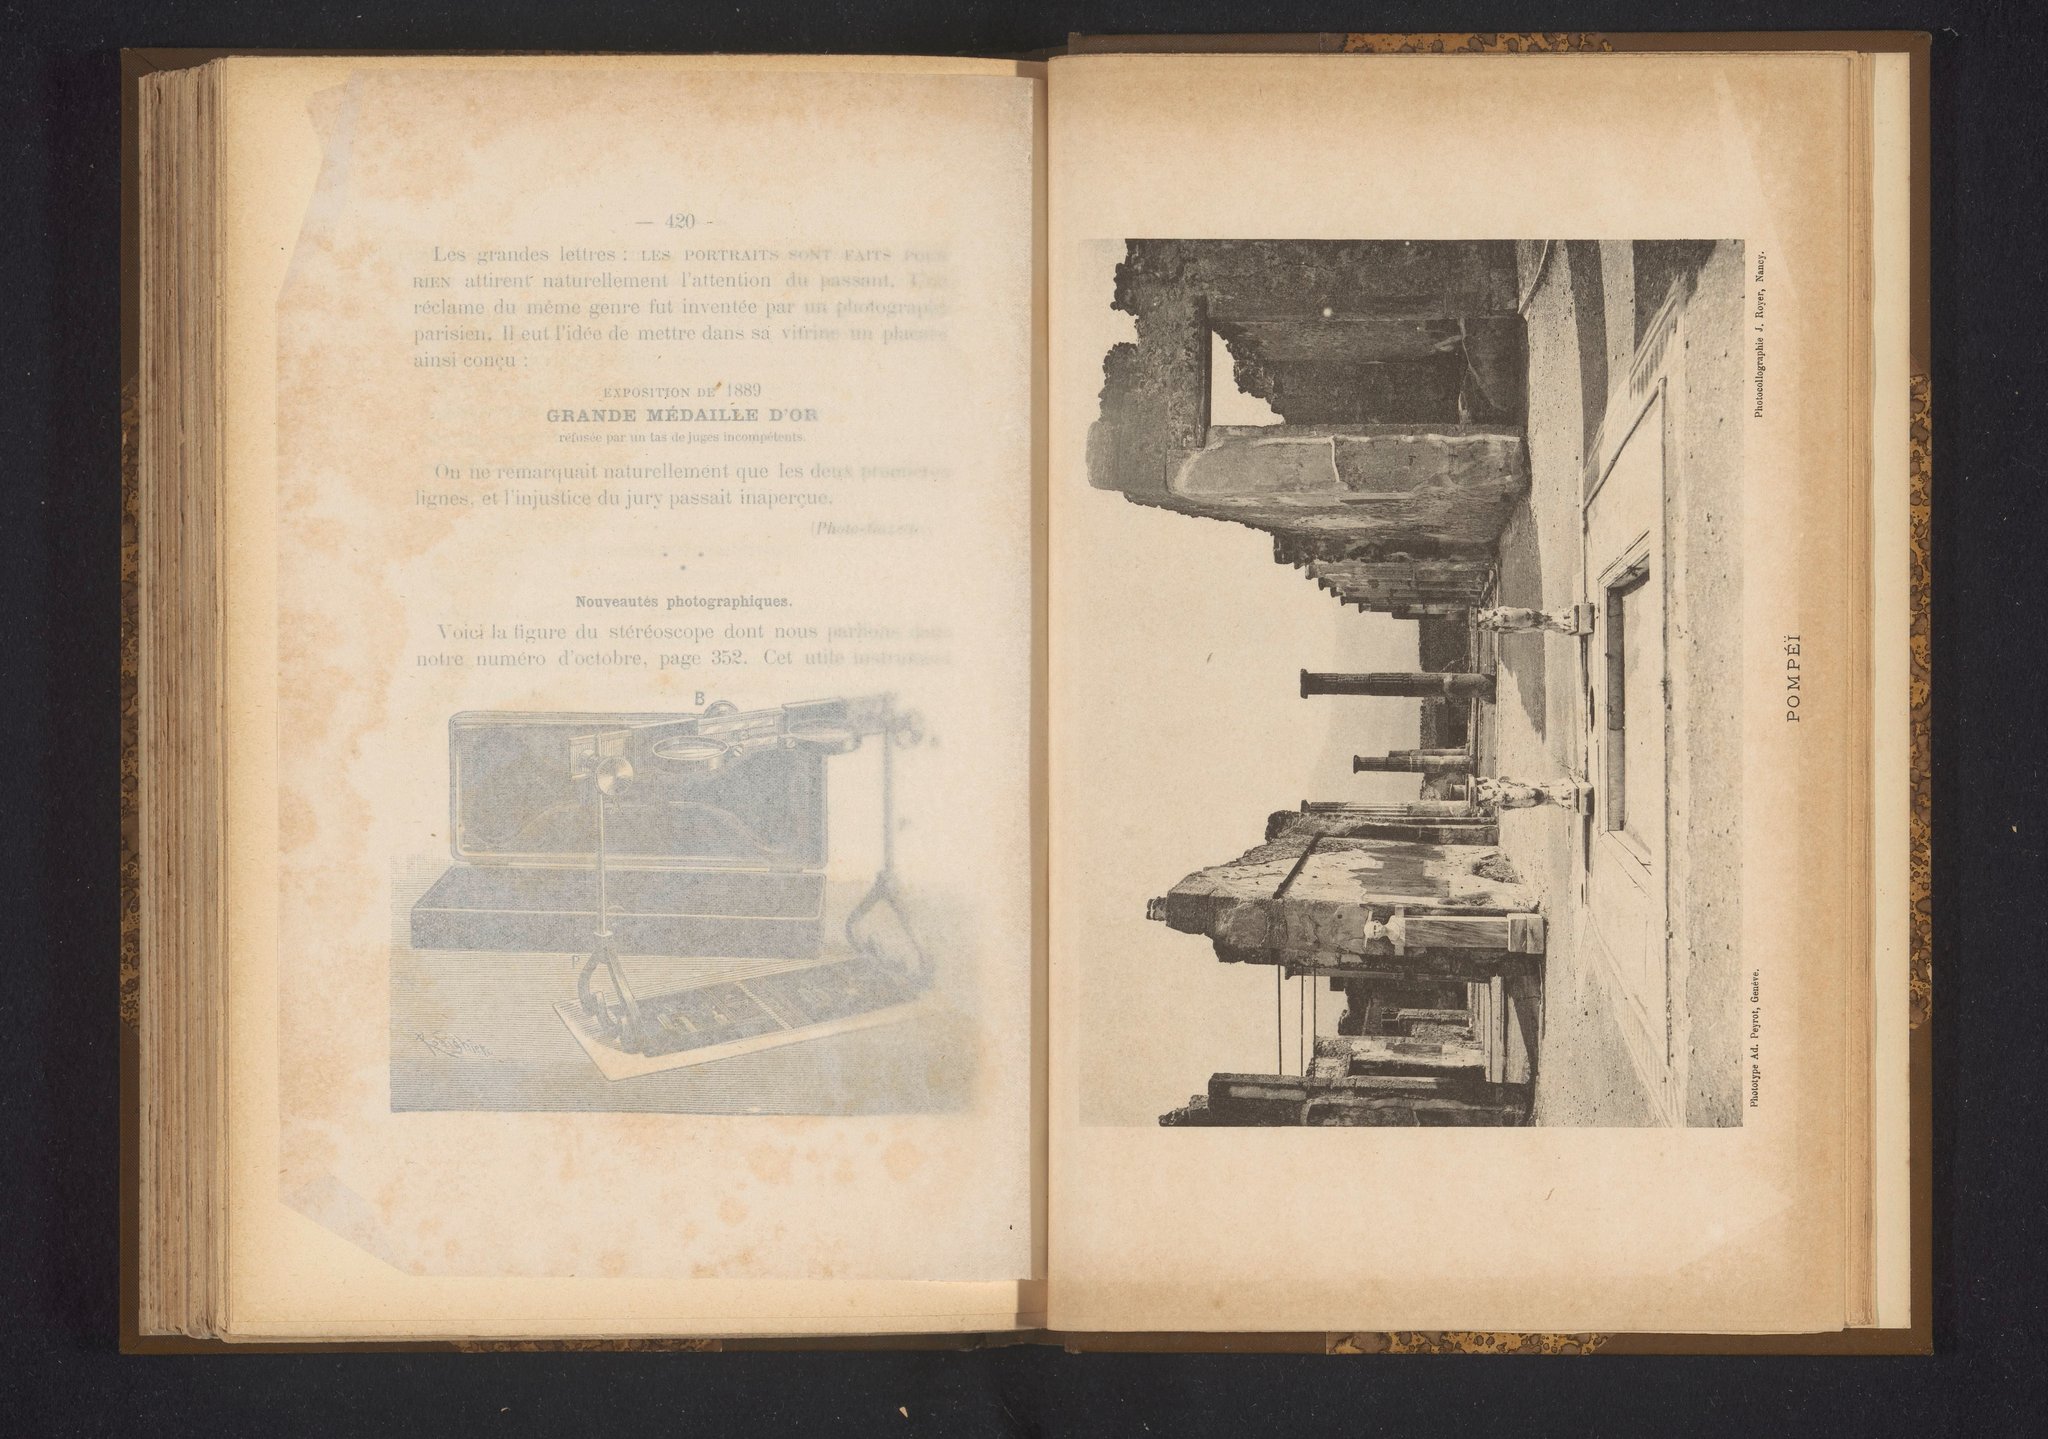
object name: photomechanical print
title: Gezicht op een ruïne in Pompeï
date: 1888-1893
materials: paper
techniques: photograph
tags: ruin of a building ~ architecture, pompeii